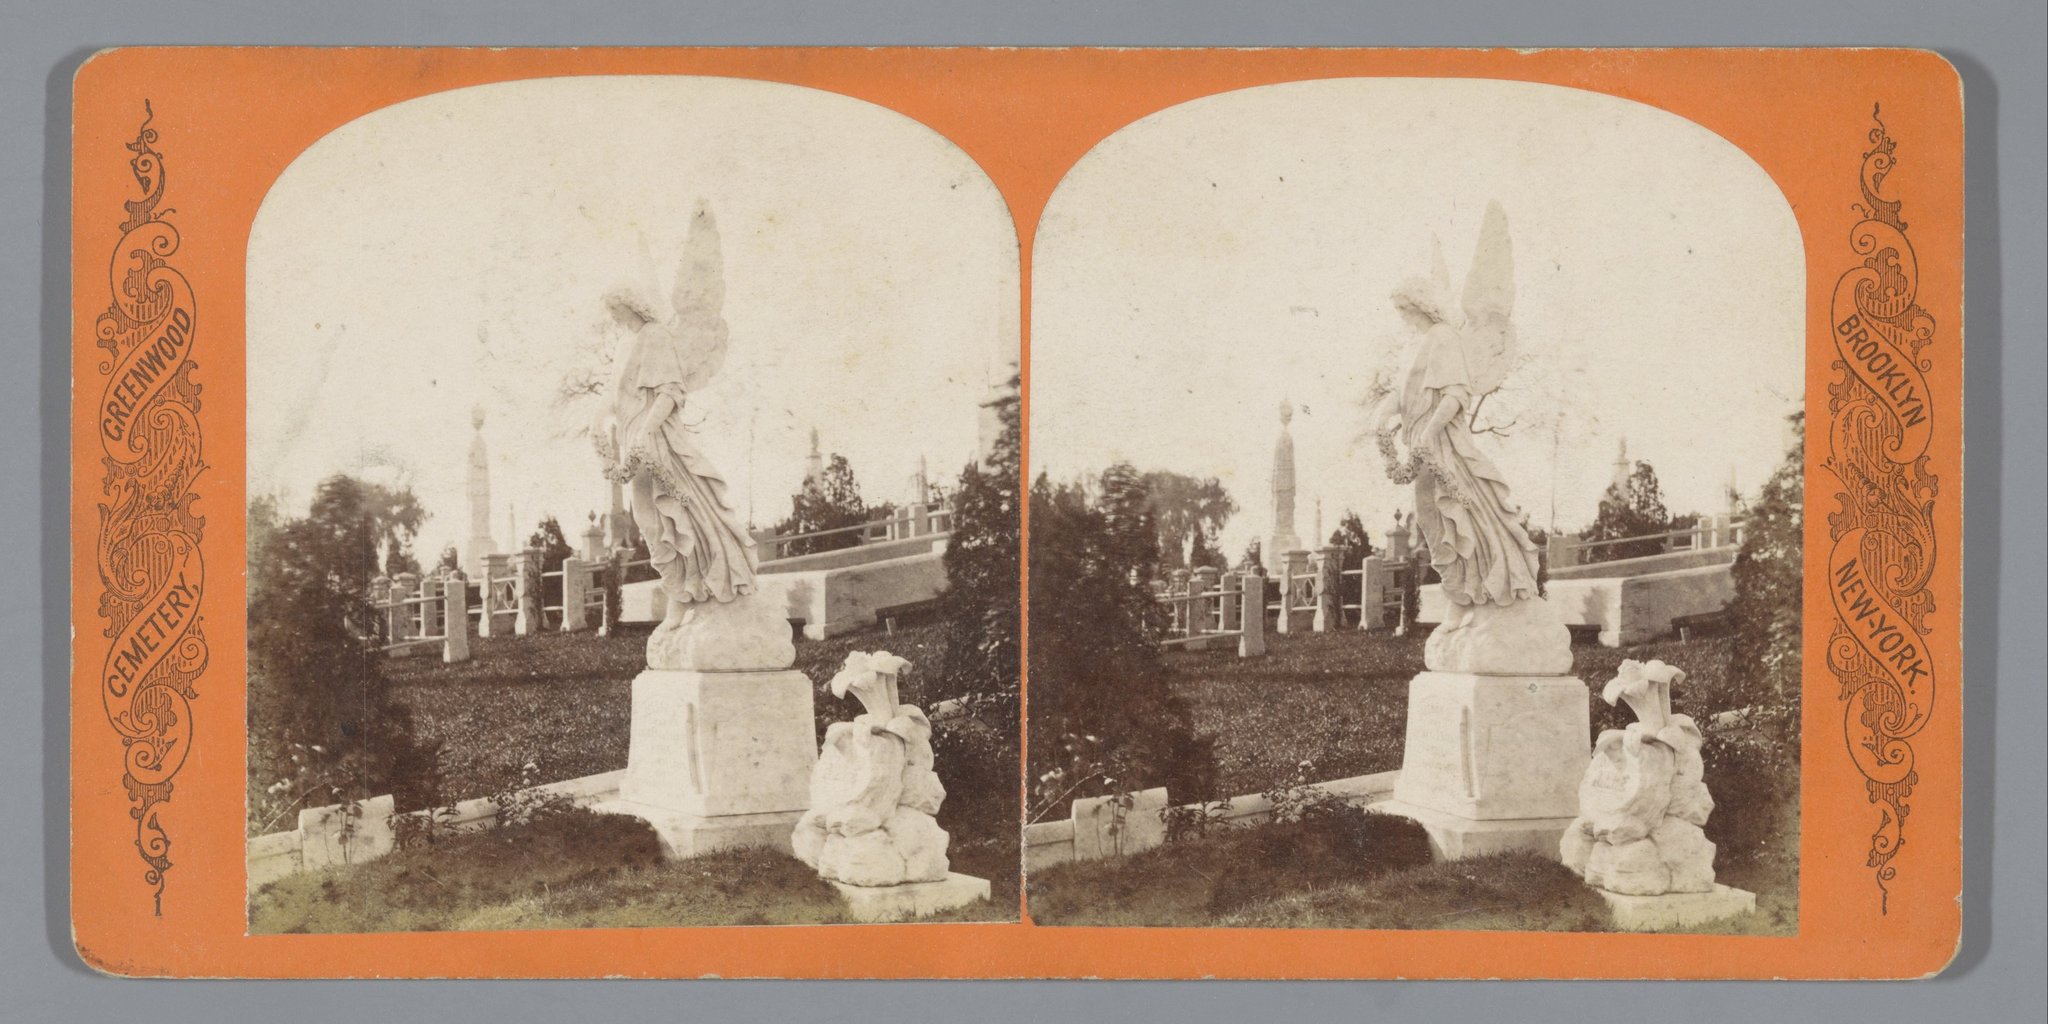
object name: stereograph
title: Gezicht op het Pierce monument op Greenwood Cemetery, New York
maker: Anonymous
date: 1868-1890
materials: cardboard, paper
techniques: albumen print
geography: new york city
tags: urn, new york (city)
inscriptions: inscription: ‘The Main Entrance (Five Views)/ Franklin Ave. Entrance/ (...)’, retailer's mark: ‘FROM/ B. and B. BAZAR./ 677 & 679 Fulton St./ BROOKLYN.’